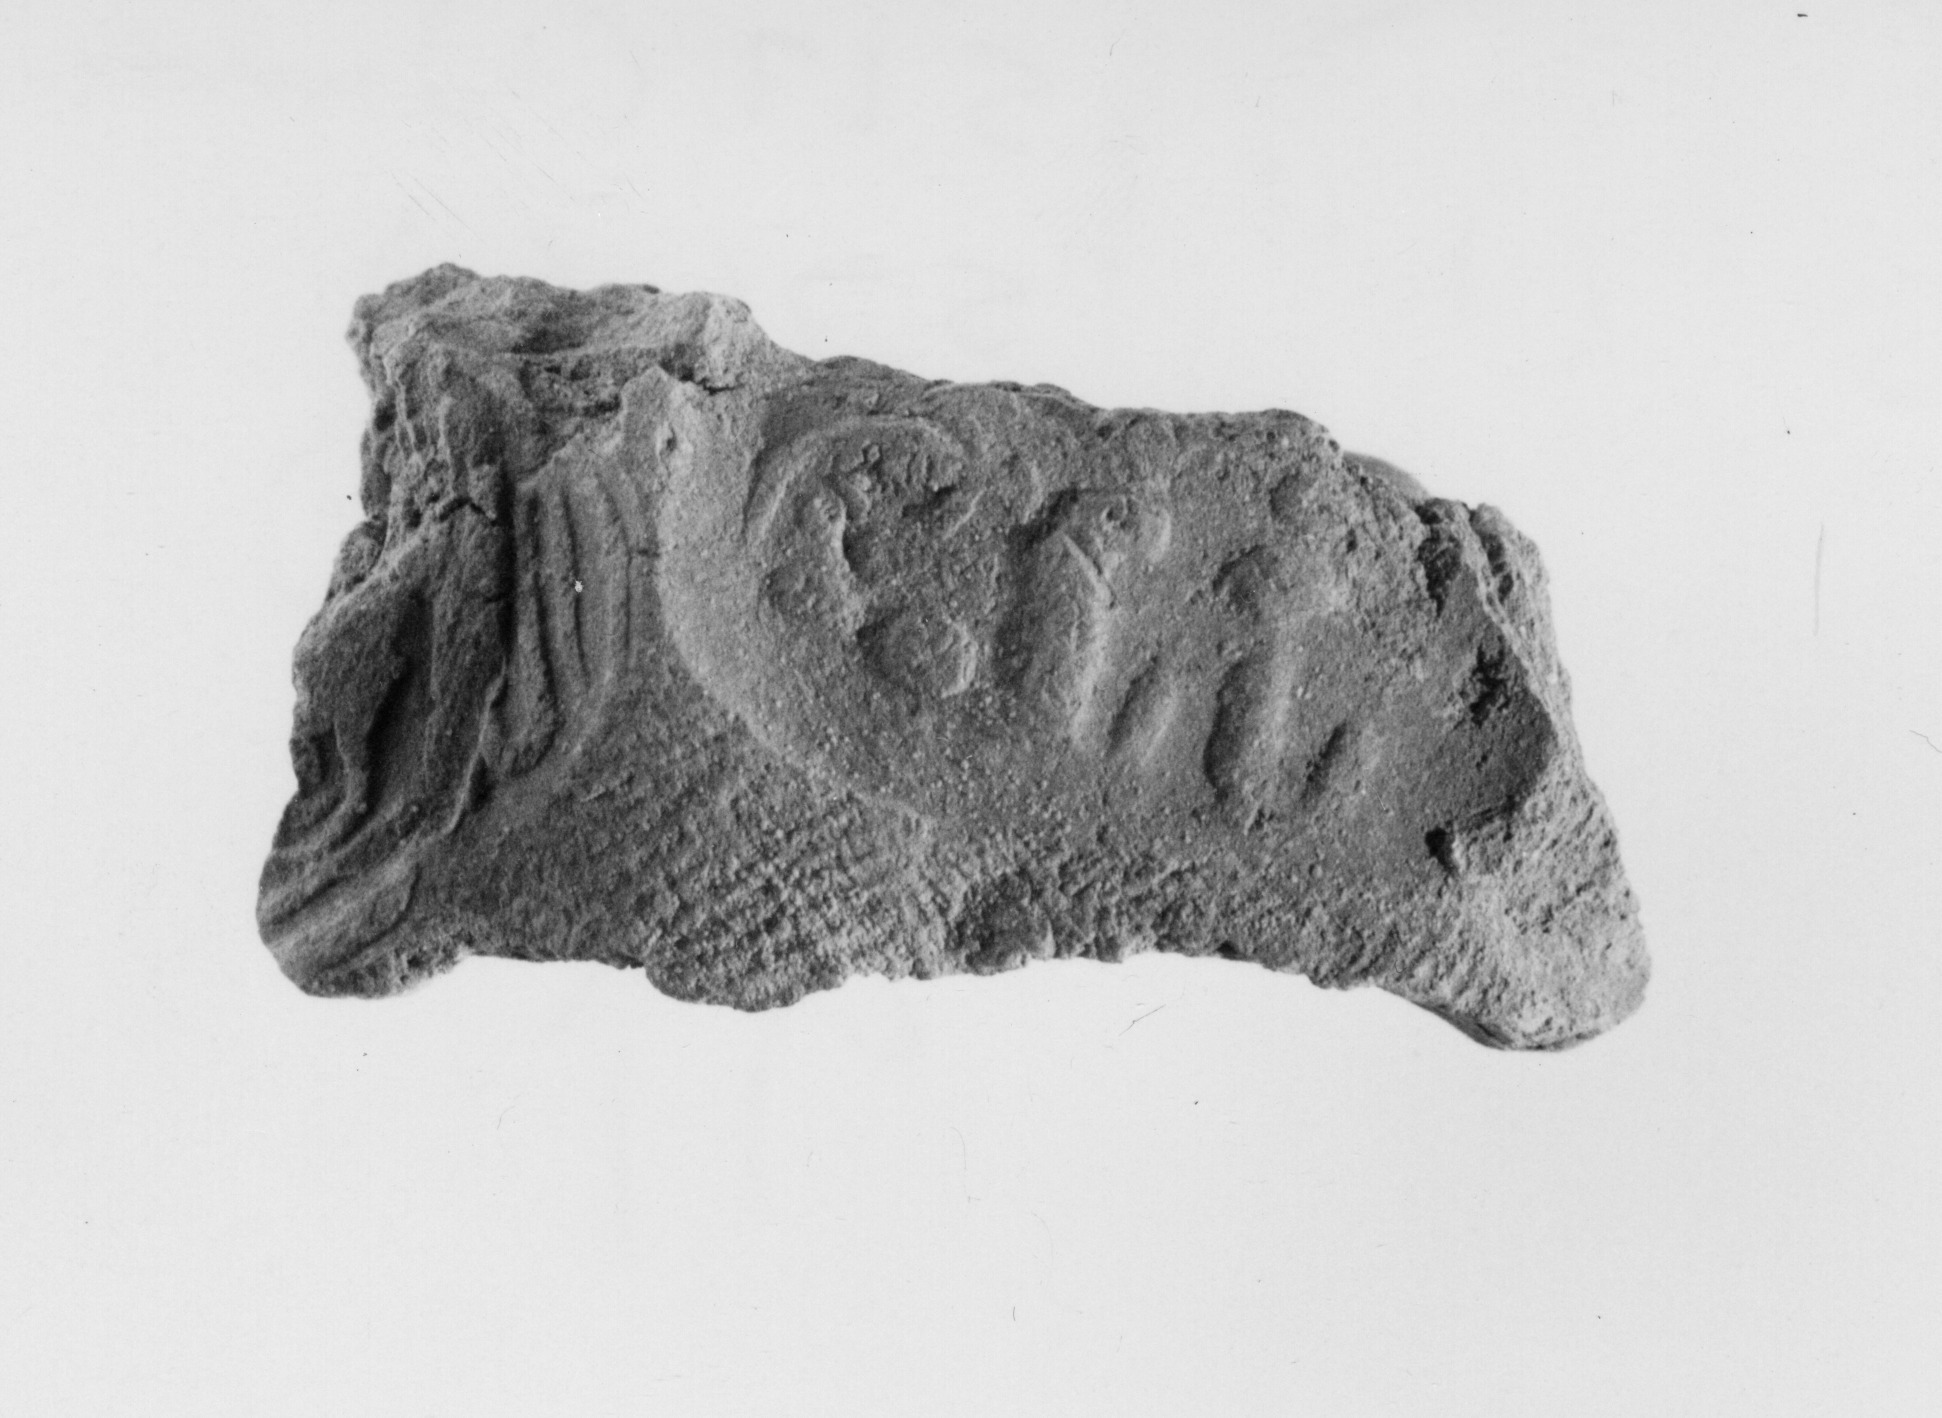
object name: sealing, amenhotep iii, nebmaatre, cobra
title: Document Sealing With Multiple Seal Impressions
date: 1390-1352 BCE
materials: mud